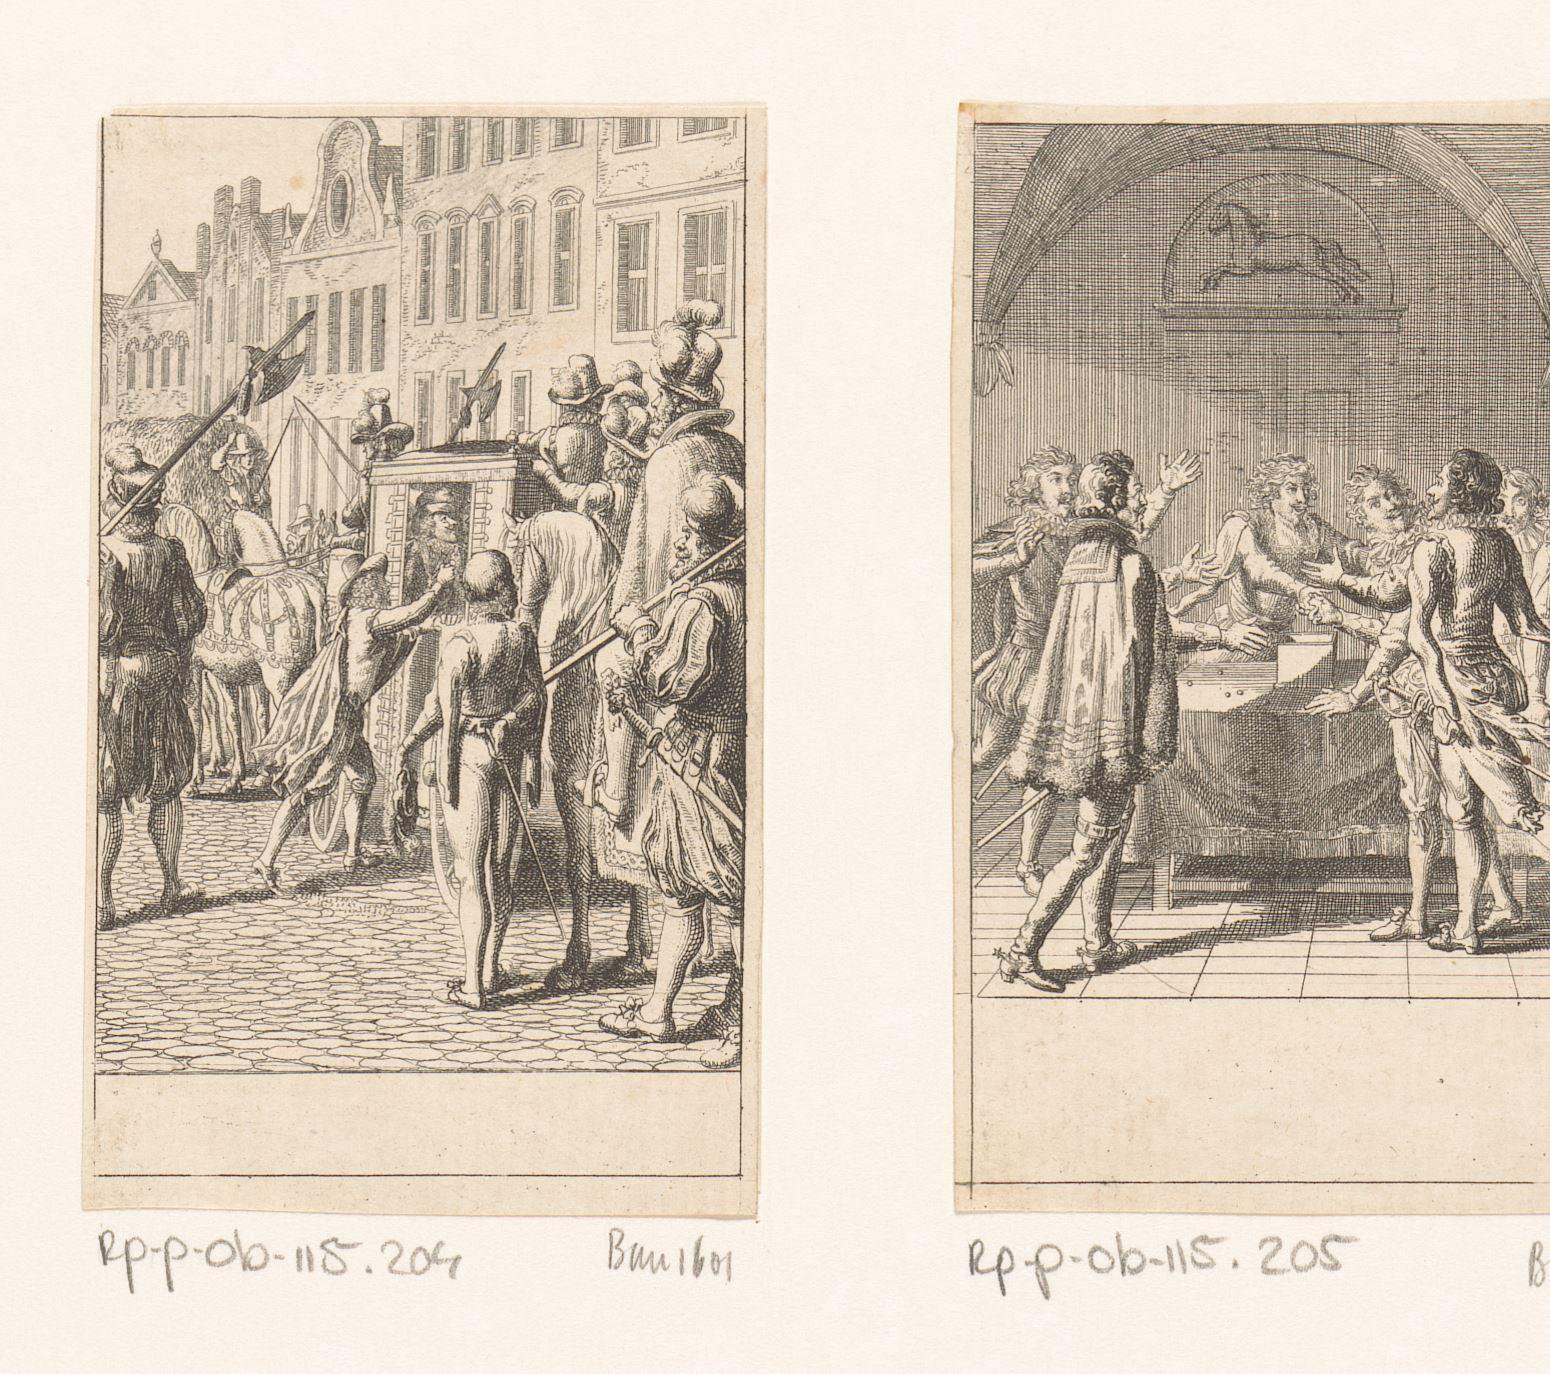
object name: print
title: Hendrik IV van Frankrijk wordt vermoord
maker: daniel nikolaus chodowiecki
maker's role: draughtsman, print maker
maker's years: 1726-1801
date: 1792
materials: paper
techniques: etching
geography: berlin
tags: paris, hendrik iv (koning van frankrijk en navarra), history, murder, ruler, sovereign, surprise attack (from ambush)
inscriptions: collector's mark: Lugt 2228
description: Latere staat gebruikt voor: Almanac de Gotha pour l'anneé 1793. Gotha: C. W. Ettinger, [1792].